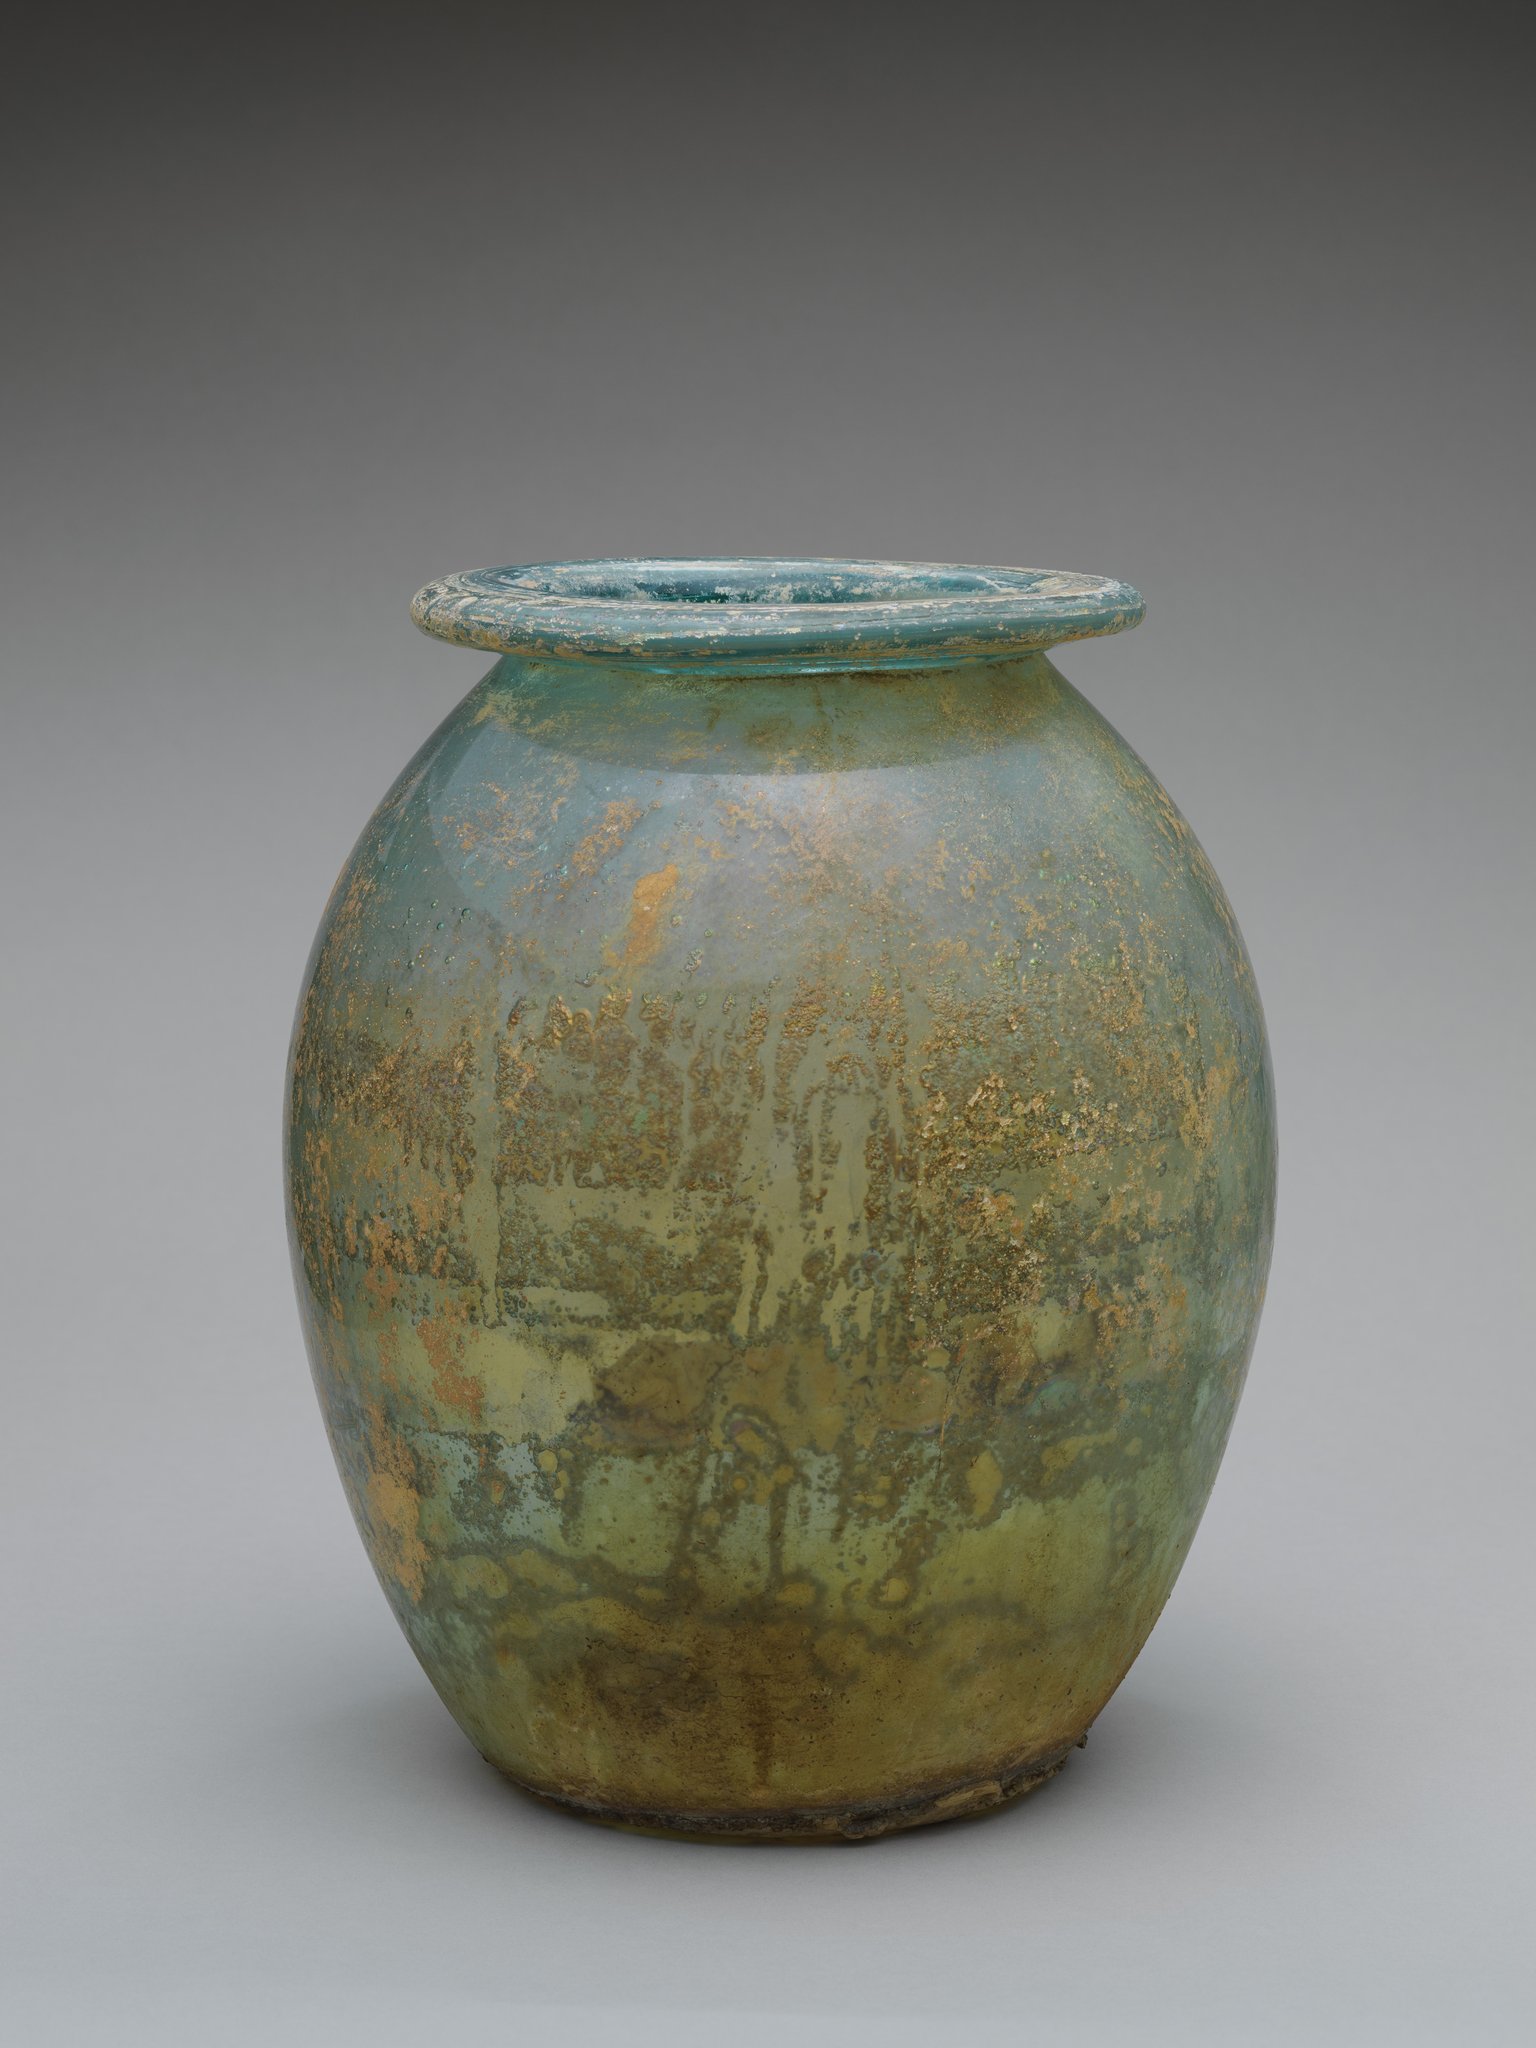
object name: jar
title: Glass cinerary urn (olla)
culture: roman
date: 34-200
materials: glass